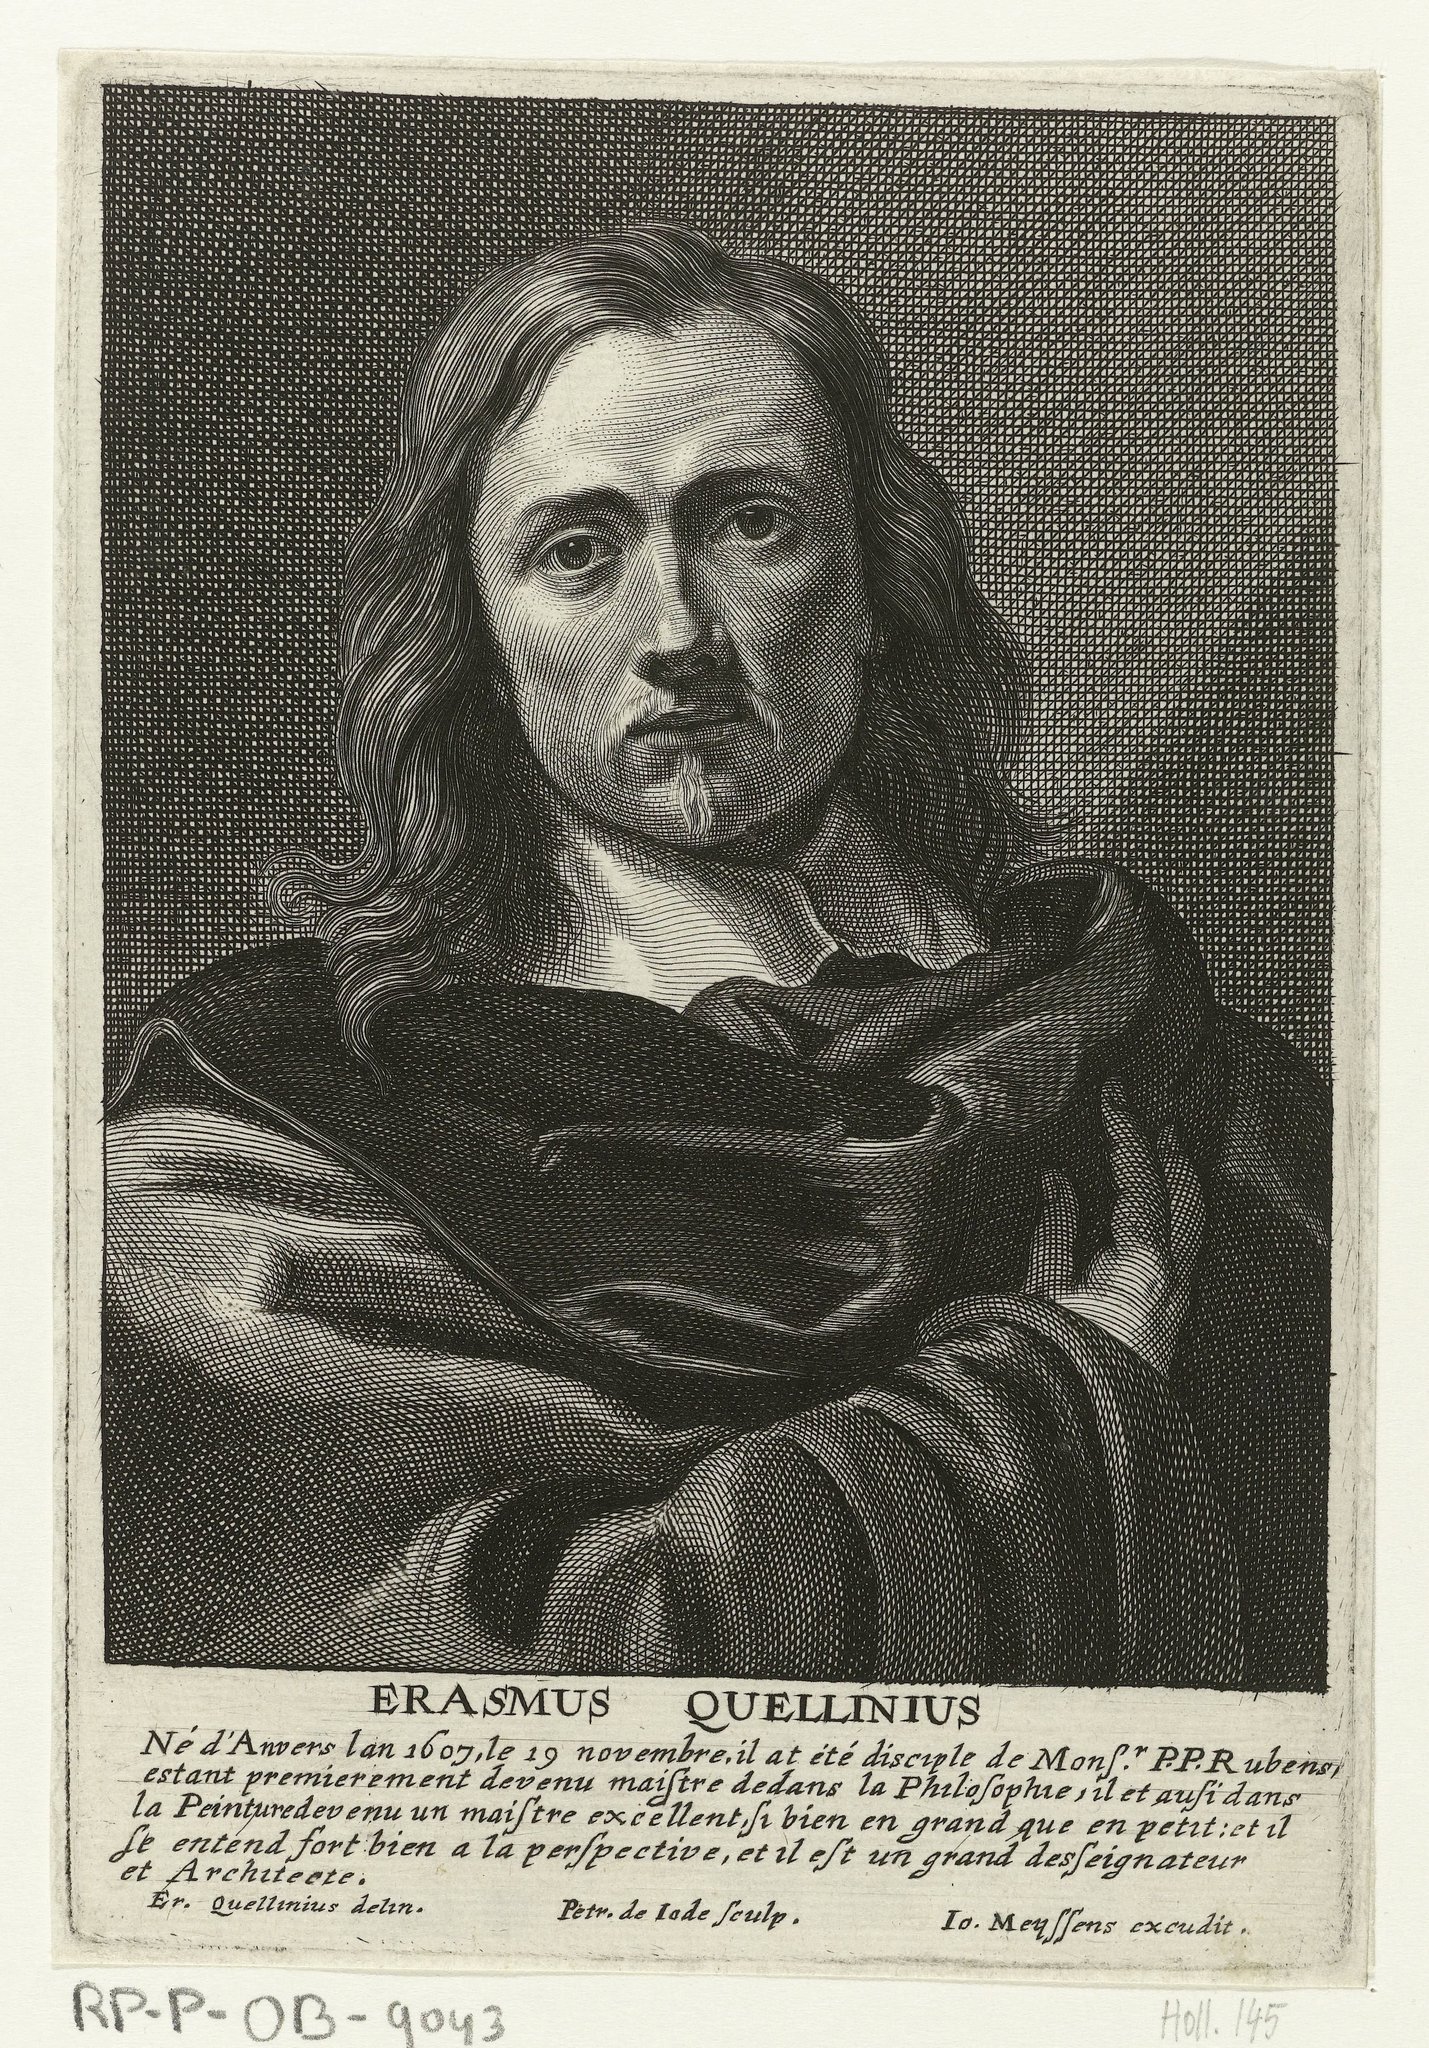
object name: print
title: Portret van Erasmus Quellinus (II)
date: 1628-1670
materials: paper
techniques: engraving, etching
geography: antwerp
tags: print maker, draughtsman, erasmus quellinus (ii)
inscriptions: collector's mark: Lugt 2228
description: Busteportret van Erasmus Quellinus (II). Hij houdt zijn rechterhand tegen zijn borst. In de marge de naam van de geportretteerde en een vijfregelig onderschrift in het Frans.